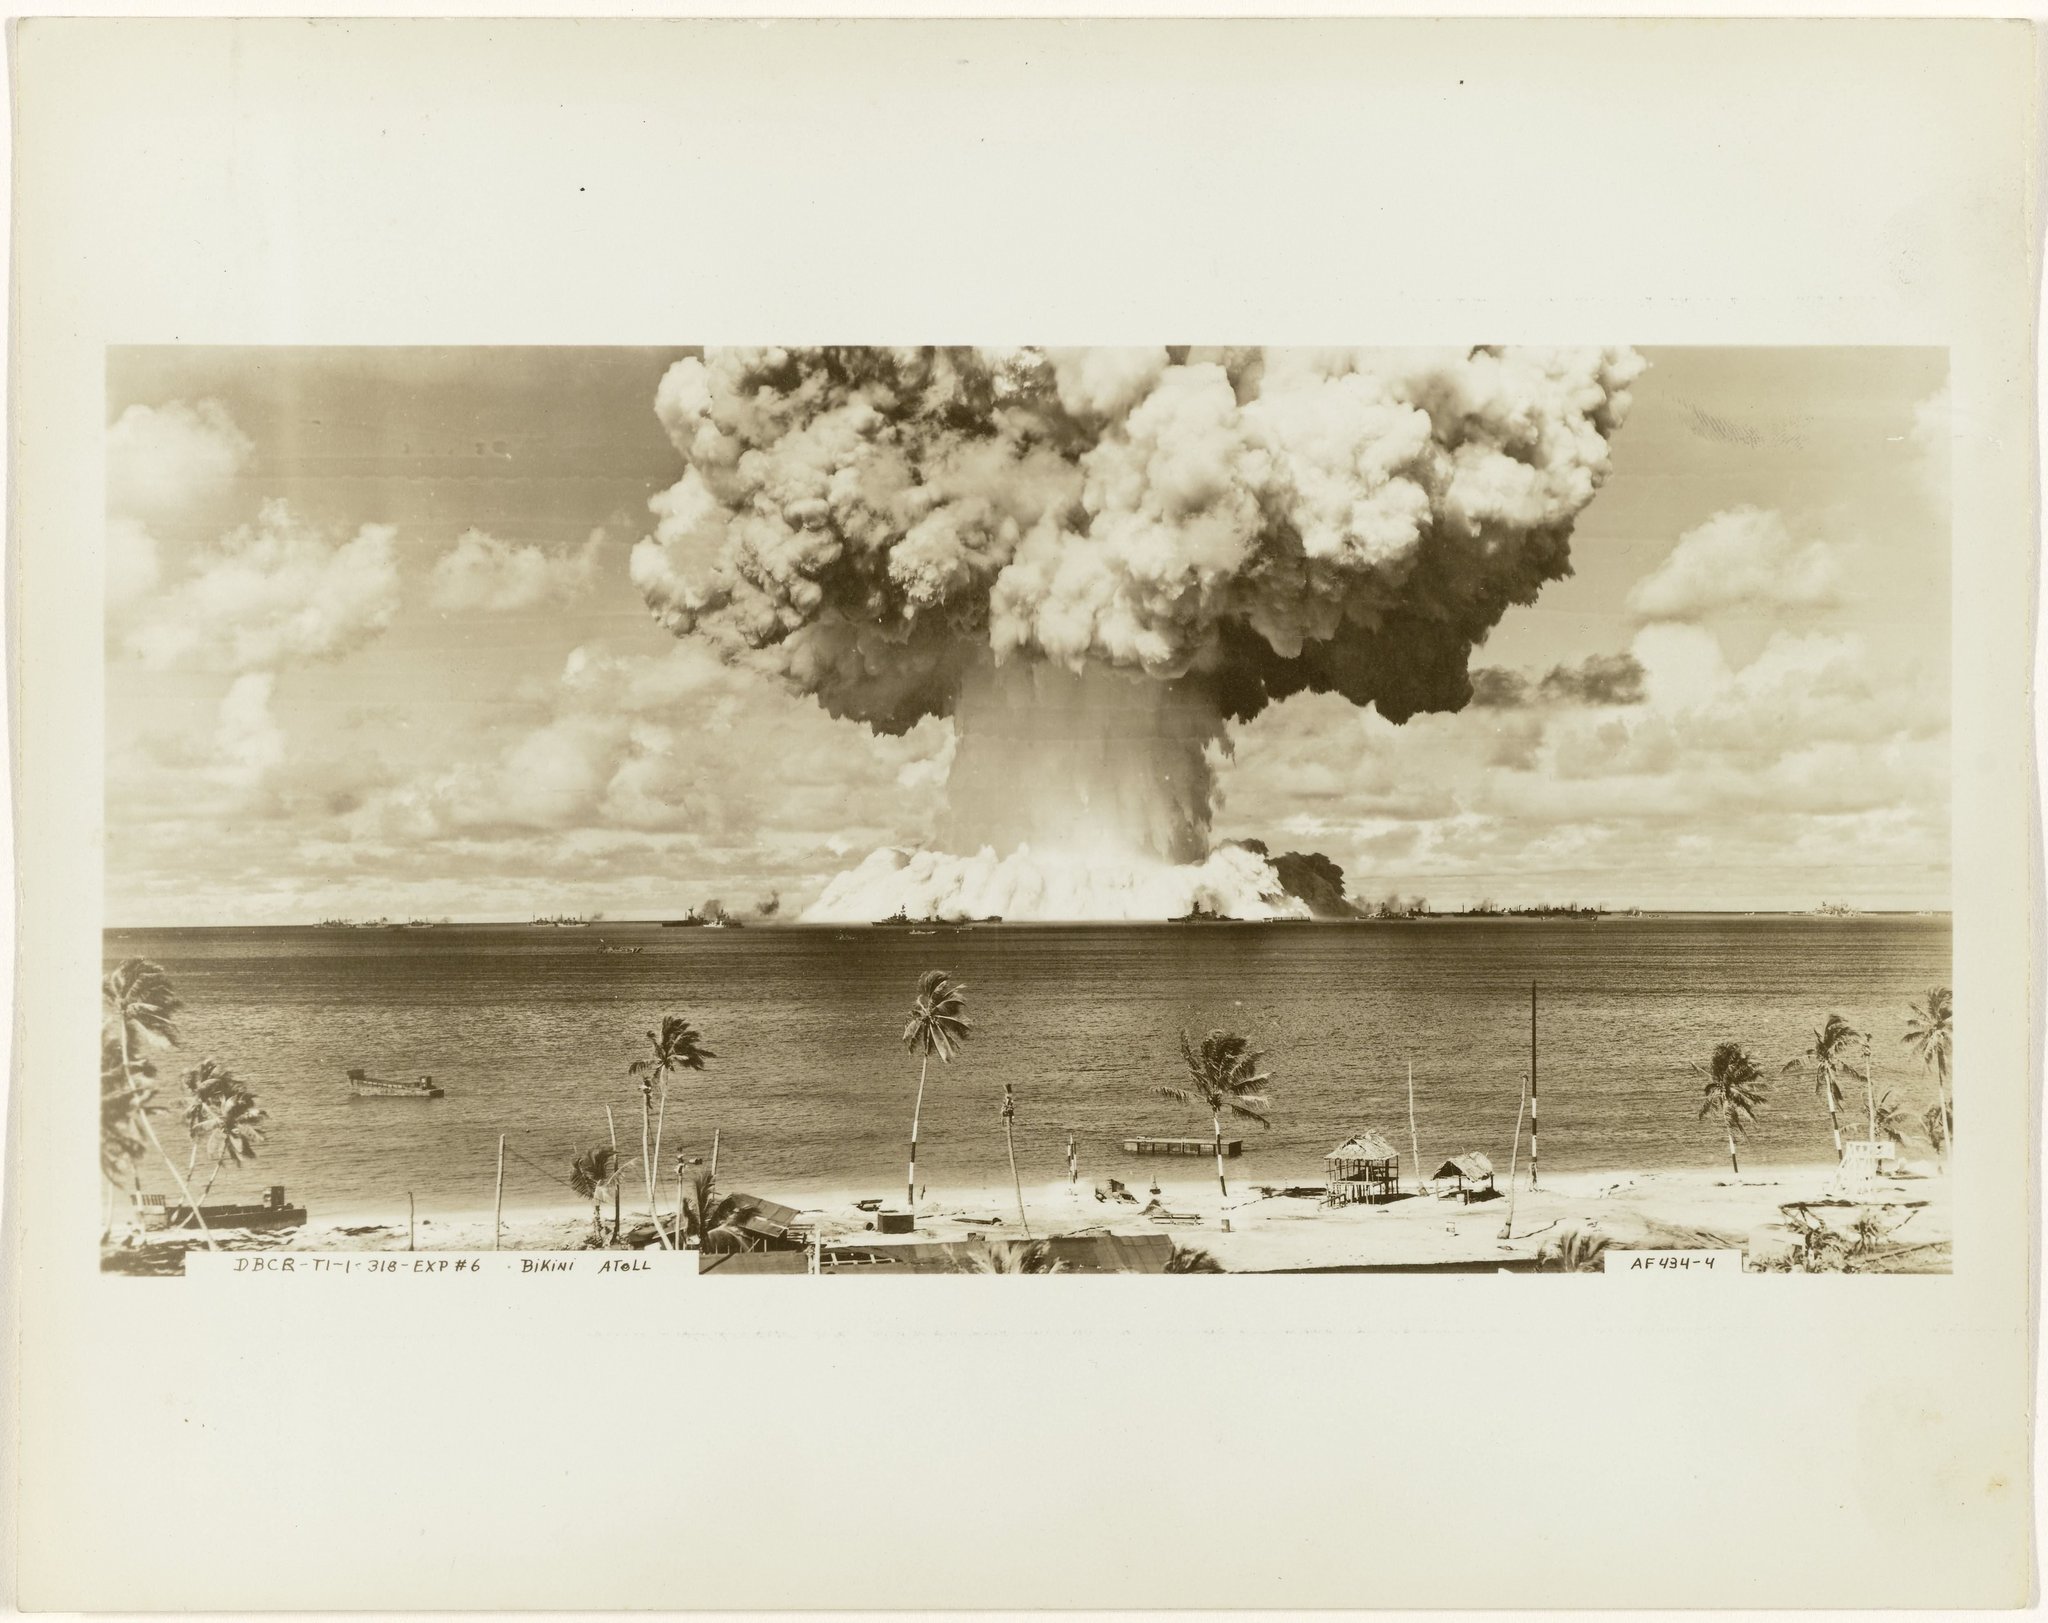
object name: photograph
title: Atomic Bomb Test during Operation Crossroads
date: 1946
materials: paper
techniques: gelatin silver print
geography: bikini atoll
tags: nuclear, biological and chemical weapons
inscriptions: inscription: ‘DBCR-T!-1-318-EXP#64 Bikini Atoll AF434-4’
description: Between 1946 and 1958 the United States experimented with nuclear weapons on Bikini Island in the Pacific. On 25 July 1946 an atomic bomb was exploded underwater along the coast. These images were printed in large format in Life magazine, with the caption: ‘It was perhaps the most awesome man-made spectacle ever photographed.’ These photographs allowed the public at large to see the destructive power of the atomic bomb for the first time.